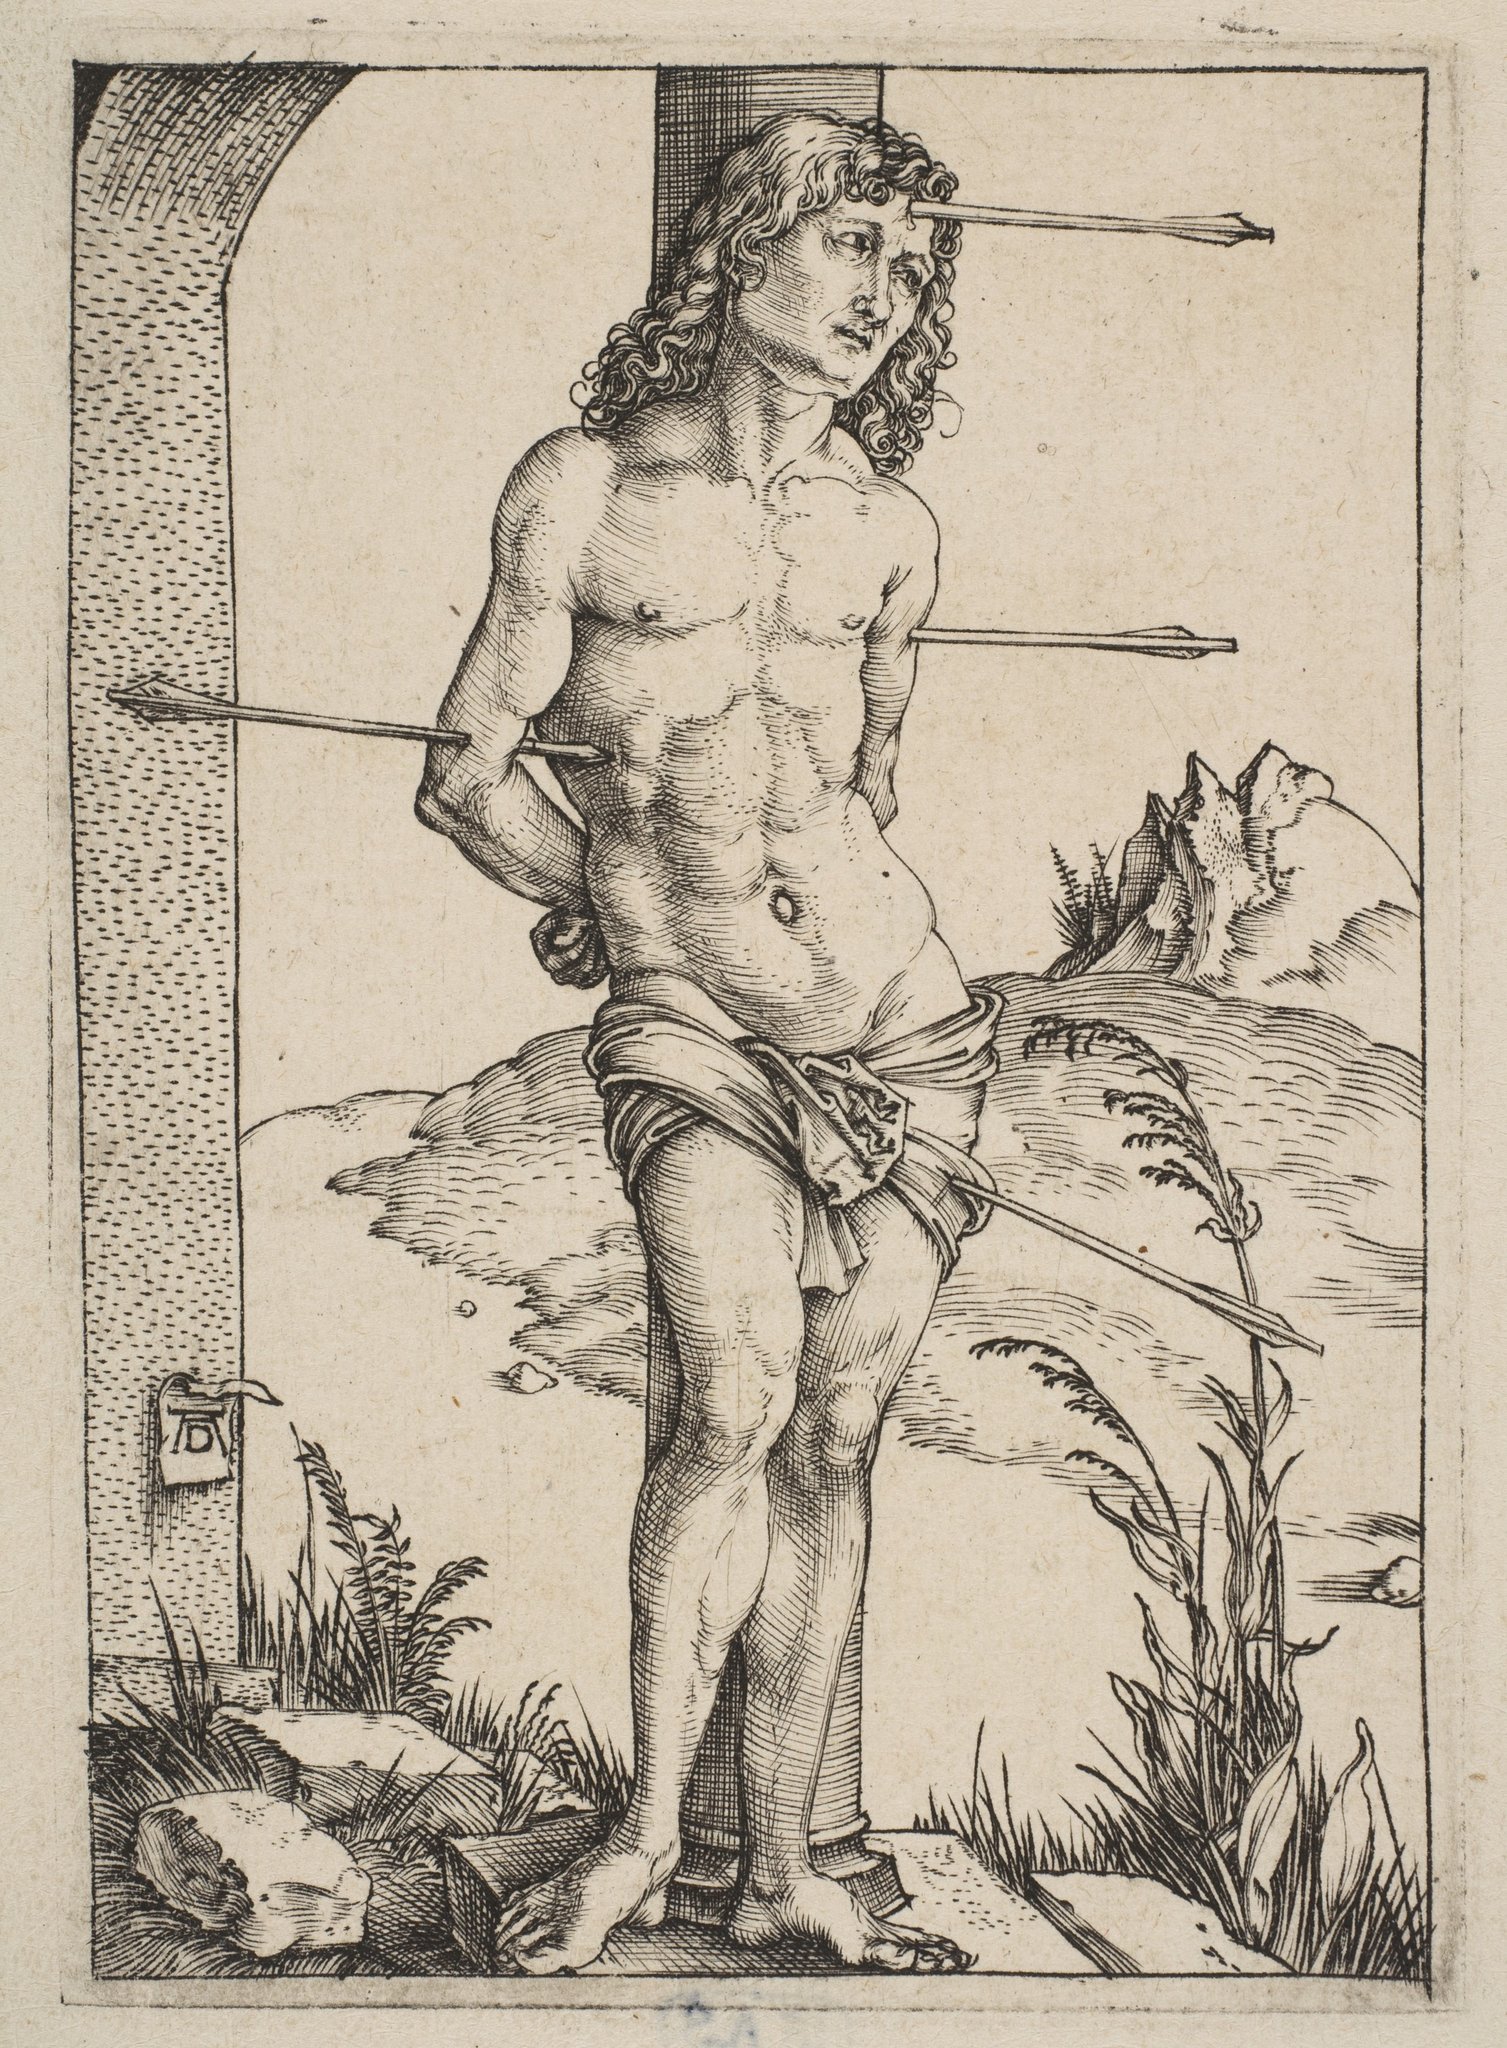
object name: print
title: Saint Sebastian Bound to the Column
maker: albrecht dürer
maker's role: artist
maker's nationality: german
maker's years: 1471-1528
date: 1499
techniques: engraving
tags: men,saints